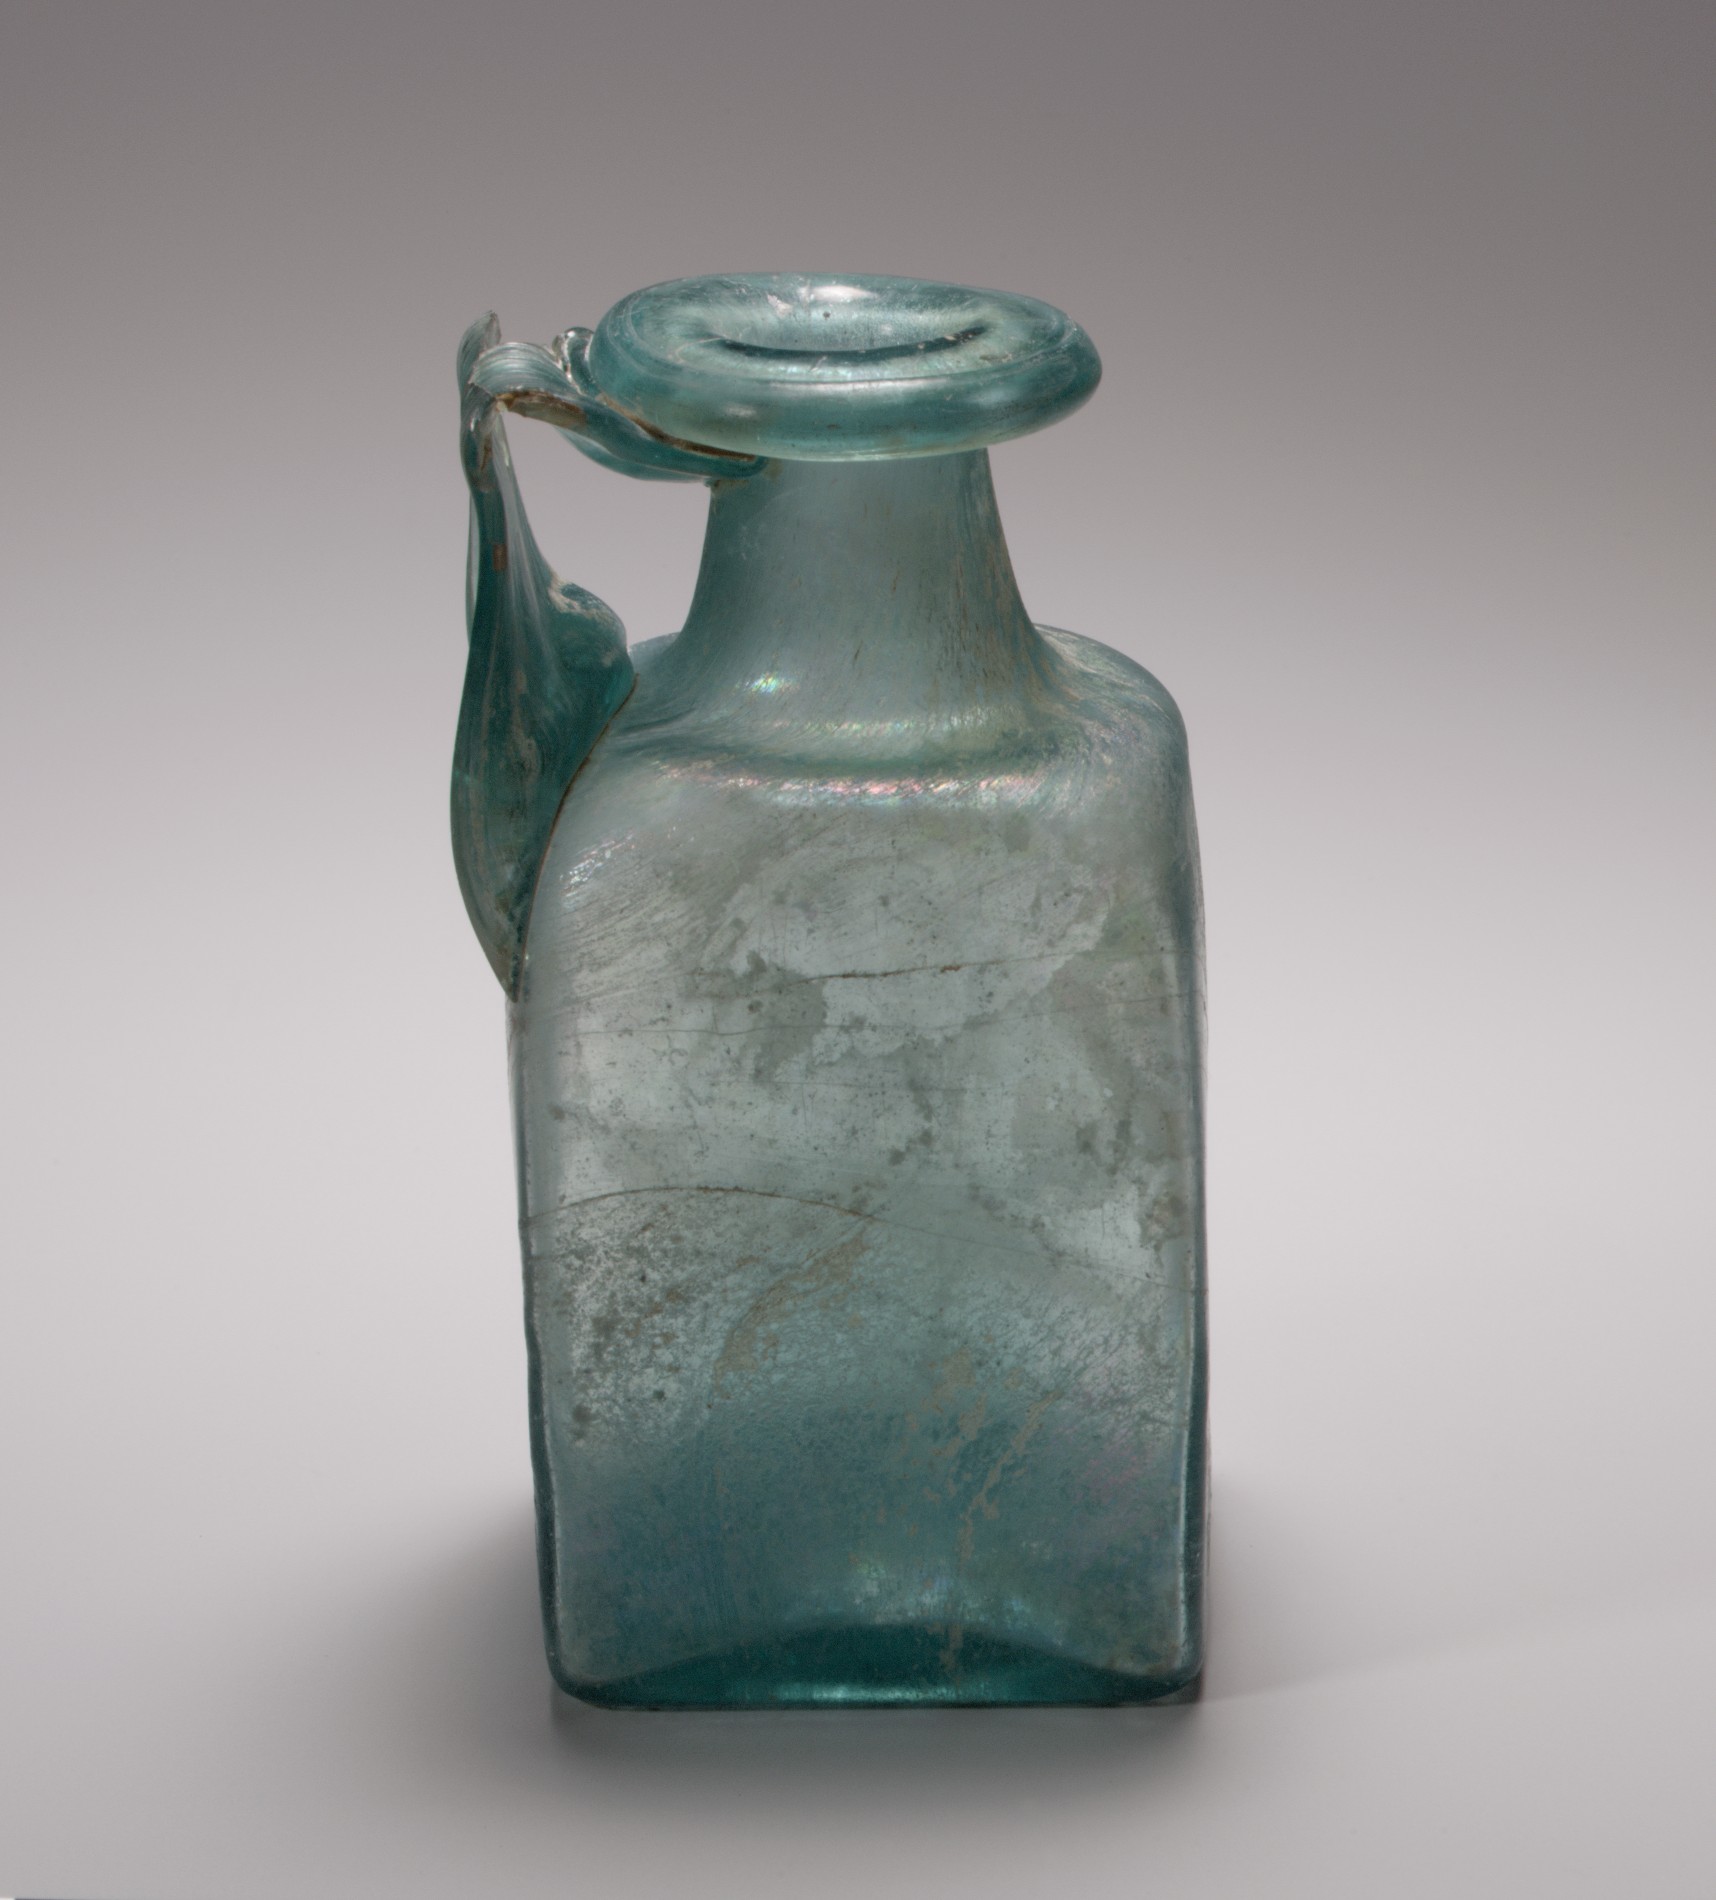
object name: bottle, square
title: Glass square bottle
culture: roman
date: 1-300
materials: glass